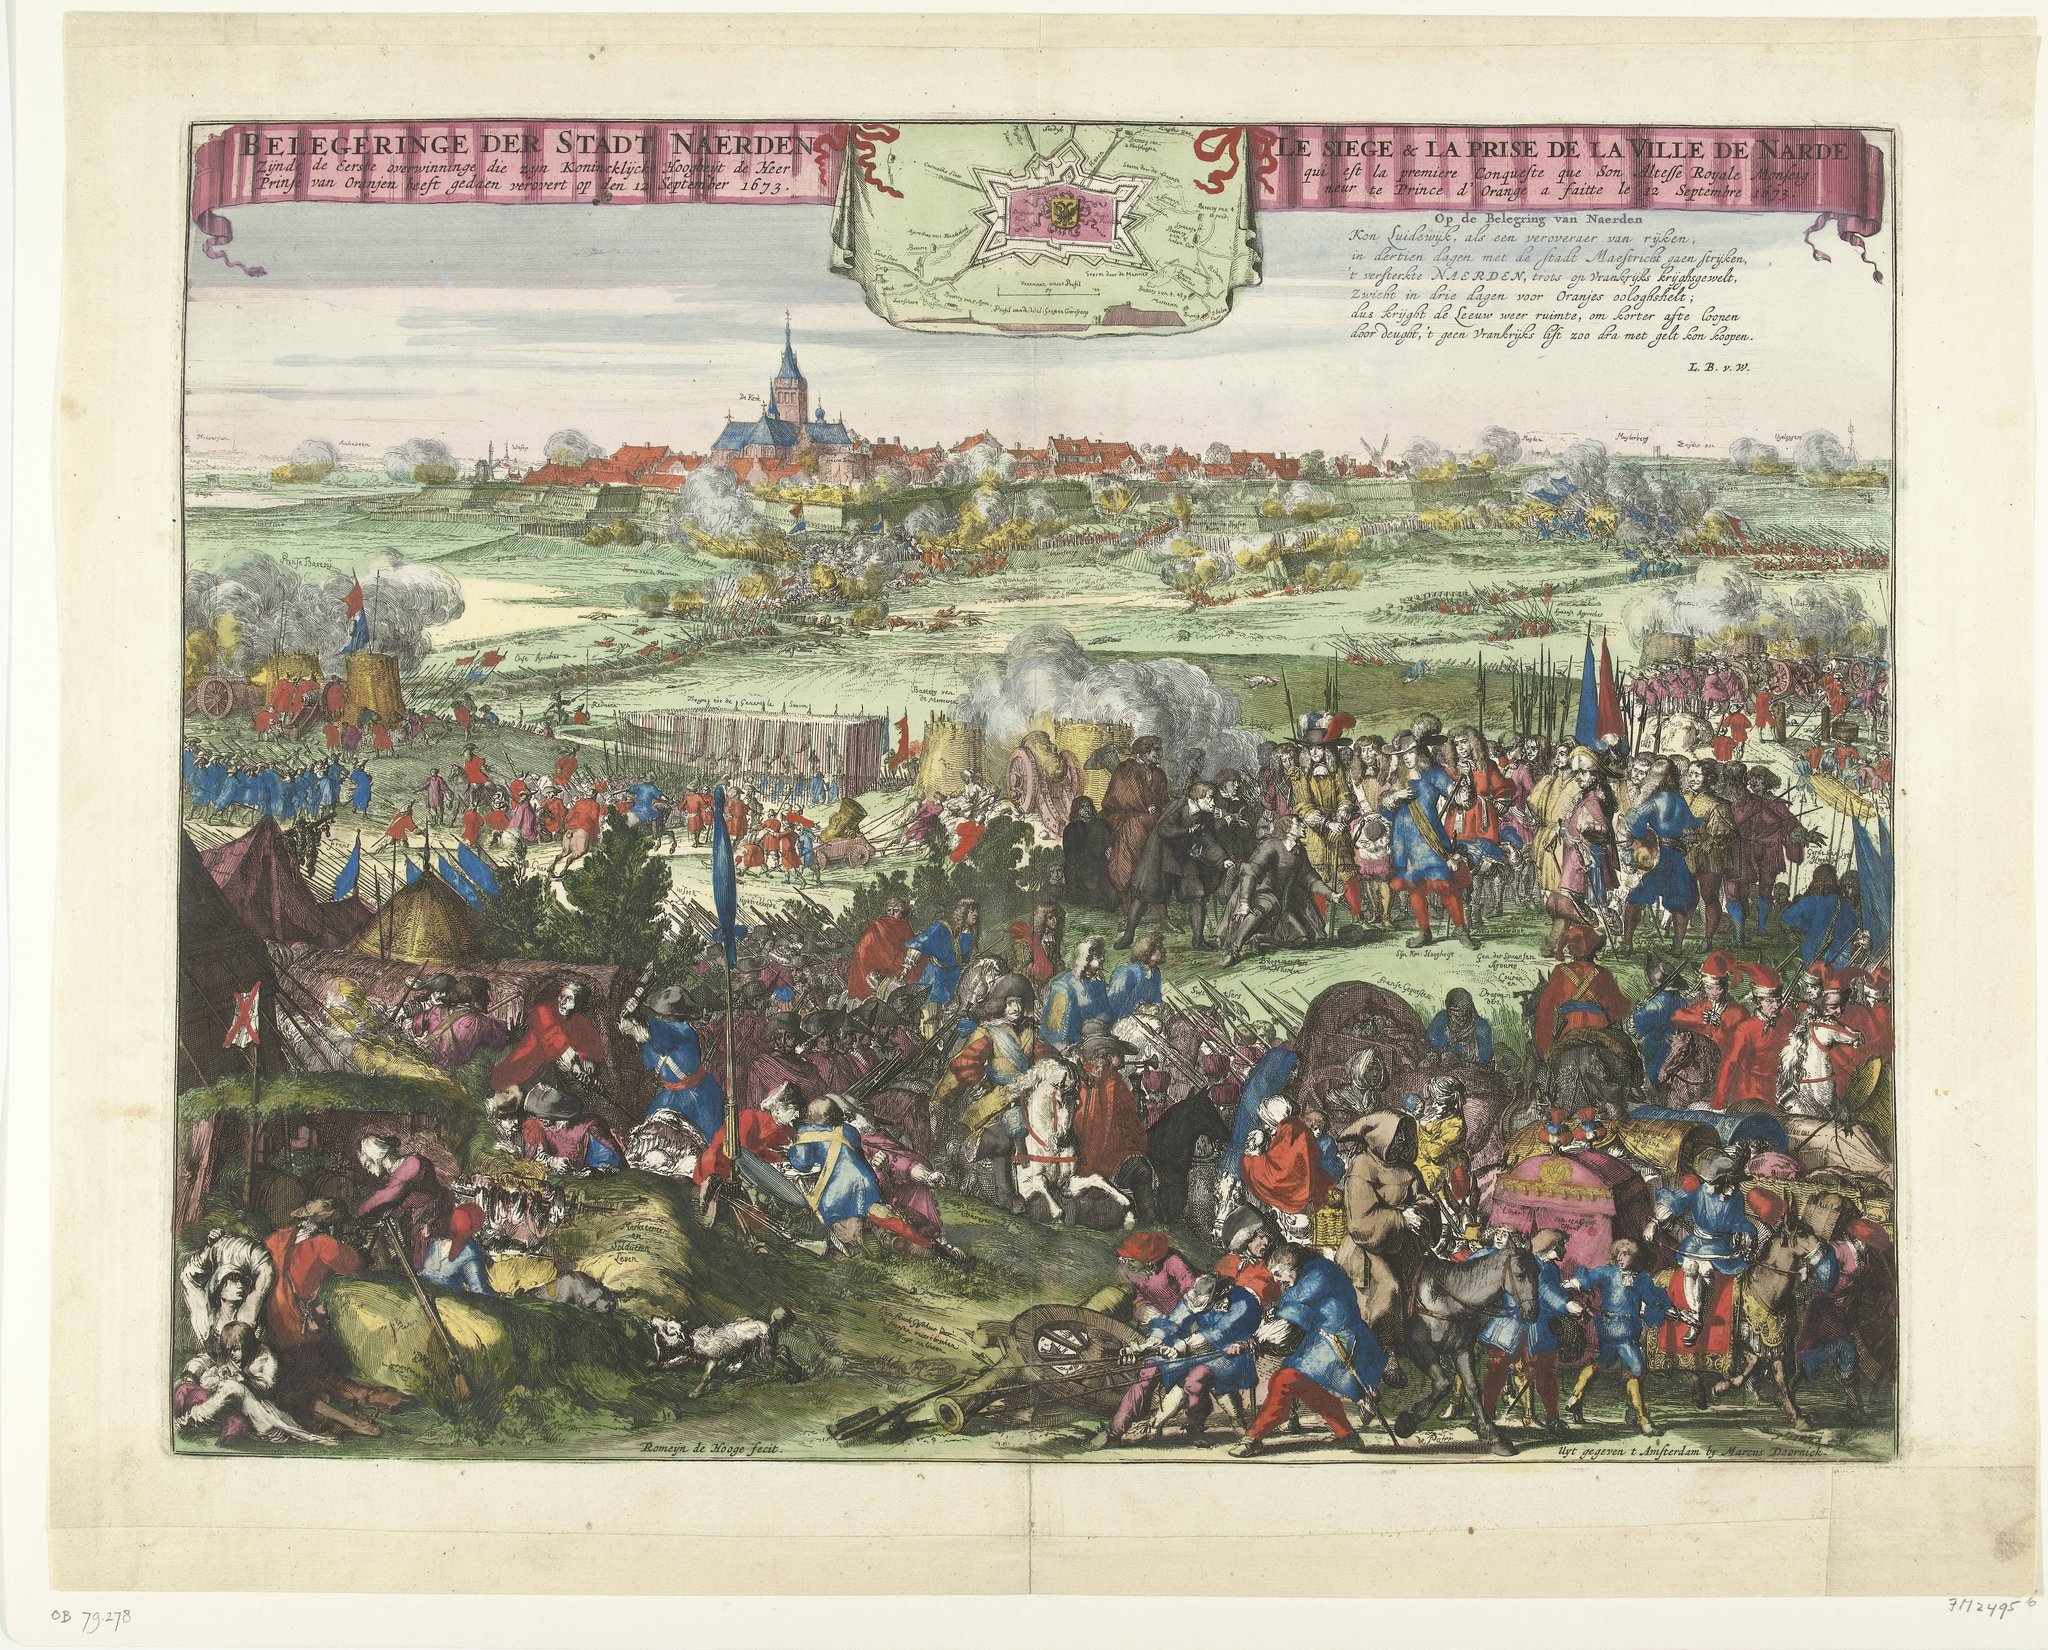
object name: print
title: Belegering en verovering van Naarden door de prins van Oranje, 1673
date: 1673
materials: paper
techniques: engraving, etching, hand coloring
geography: northern netherlands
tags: the hague, william iii (prince of orange and king of england, scotland, and ireland), siege, position war, capture of city (after the siege)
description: Belegering en verovering van Naarden door de prins van Oranje, 12 september 1673. Op de voorgrond scènes uit het soldatenleven in het legerkamp. In het midden knielt de burgemeester van Naarden voor de prins die wordt omringd door zijn staf van officieren. In de verte het beleg en de bestorming van de stad. Bovenaan op een opgehangen doek een kaartje van de stad en de posities van de belegeraars, hiernaast een vers 'Op de Belegering van Naerden' in zes regels. Met meerdere opschriften in de voorstelling.